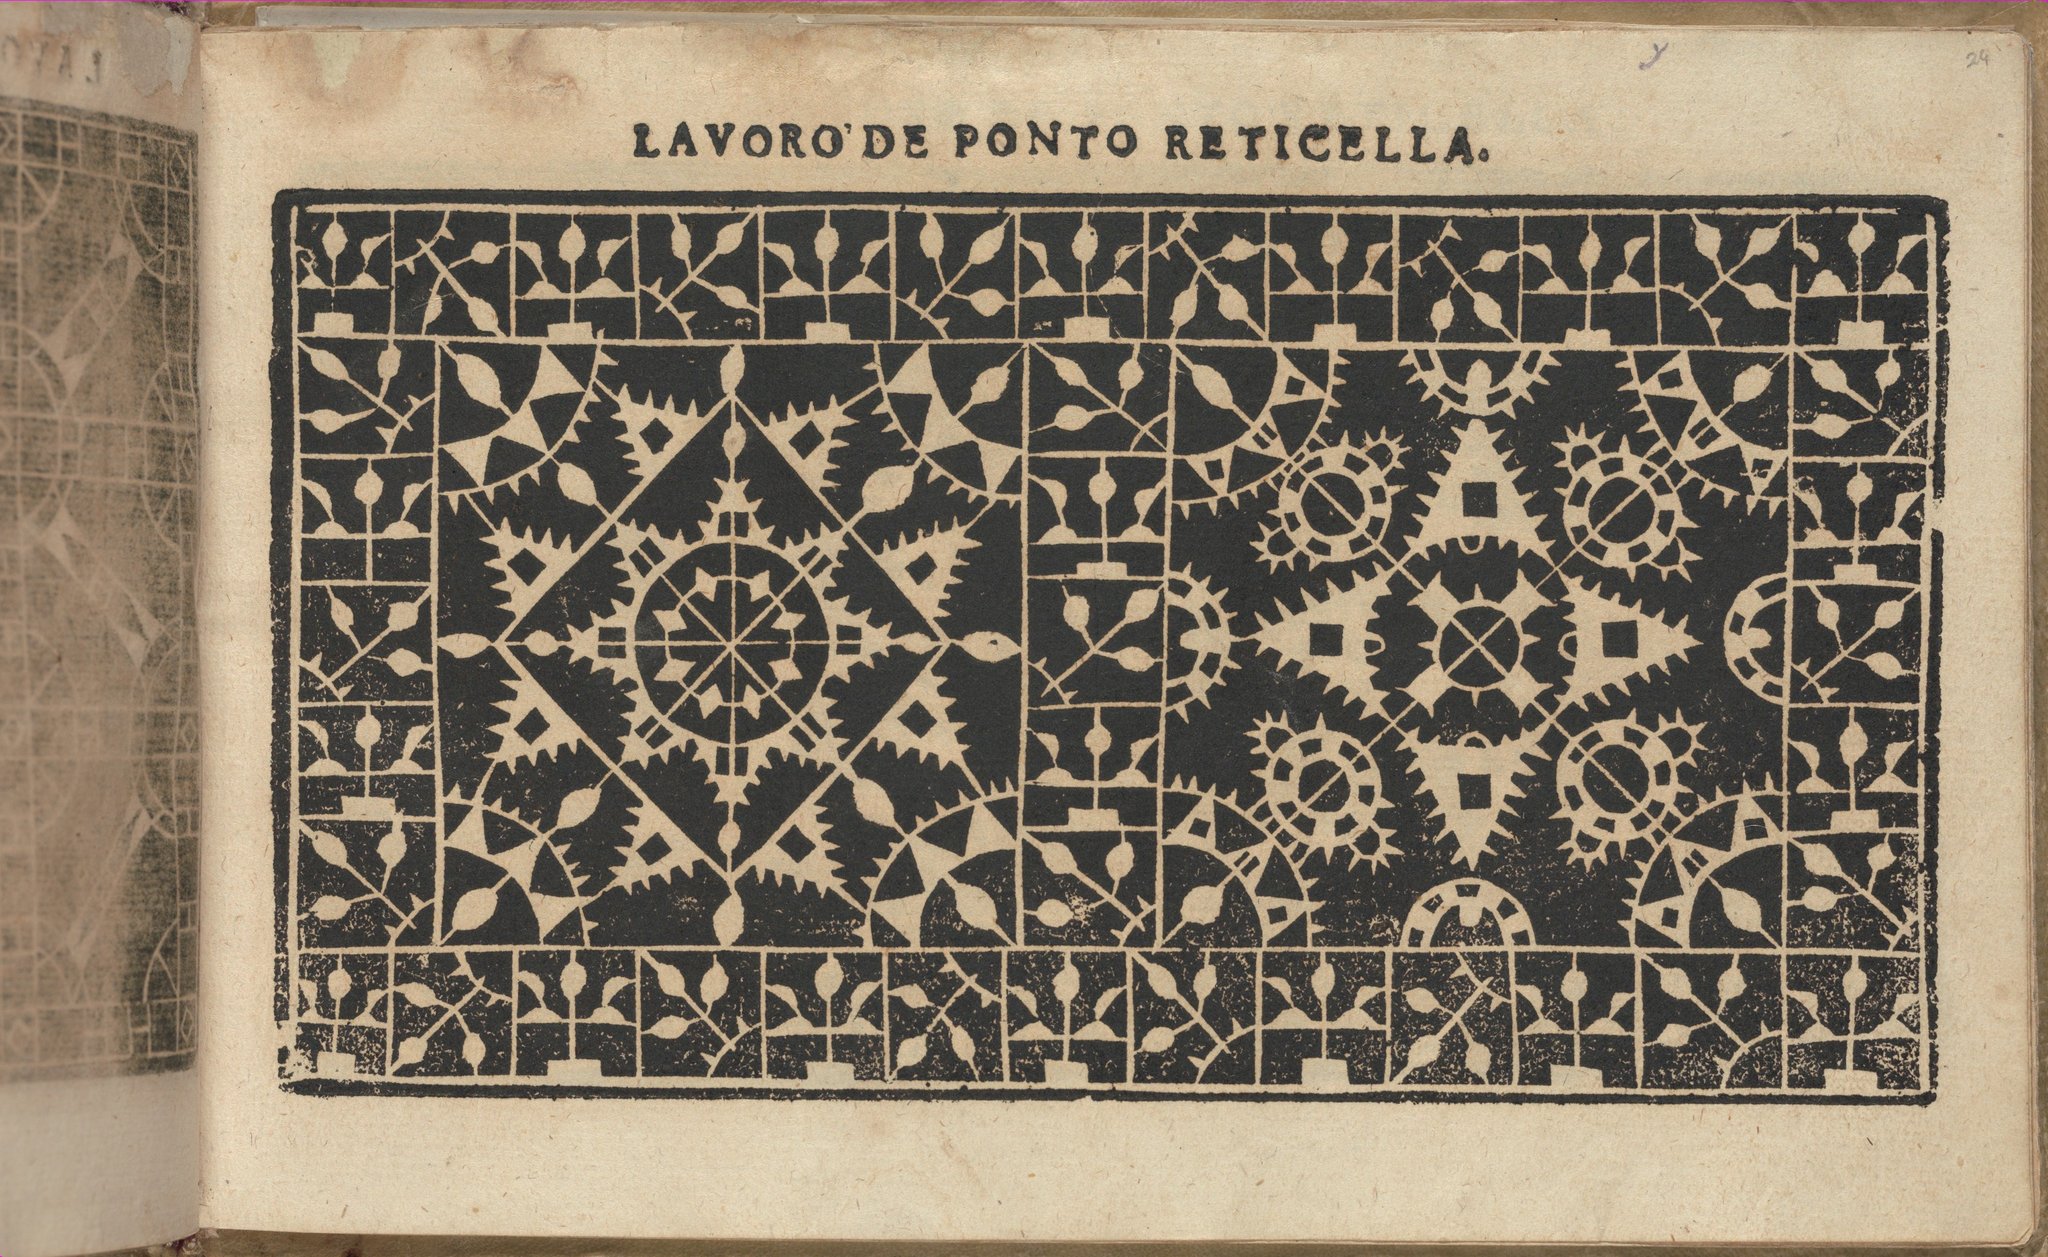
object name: book print ornament architecture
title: Studio delle virtuose Dame, page 29 (recto)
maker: isabella catanea parasole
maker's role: designer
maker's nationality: italian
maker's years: 1565-1625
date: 1597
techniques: woodcut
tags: ornament